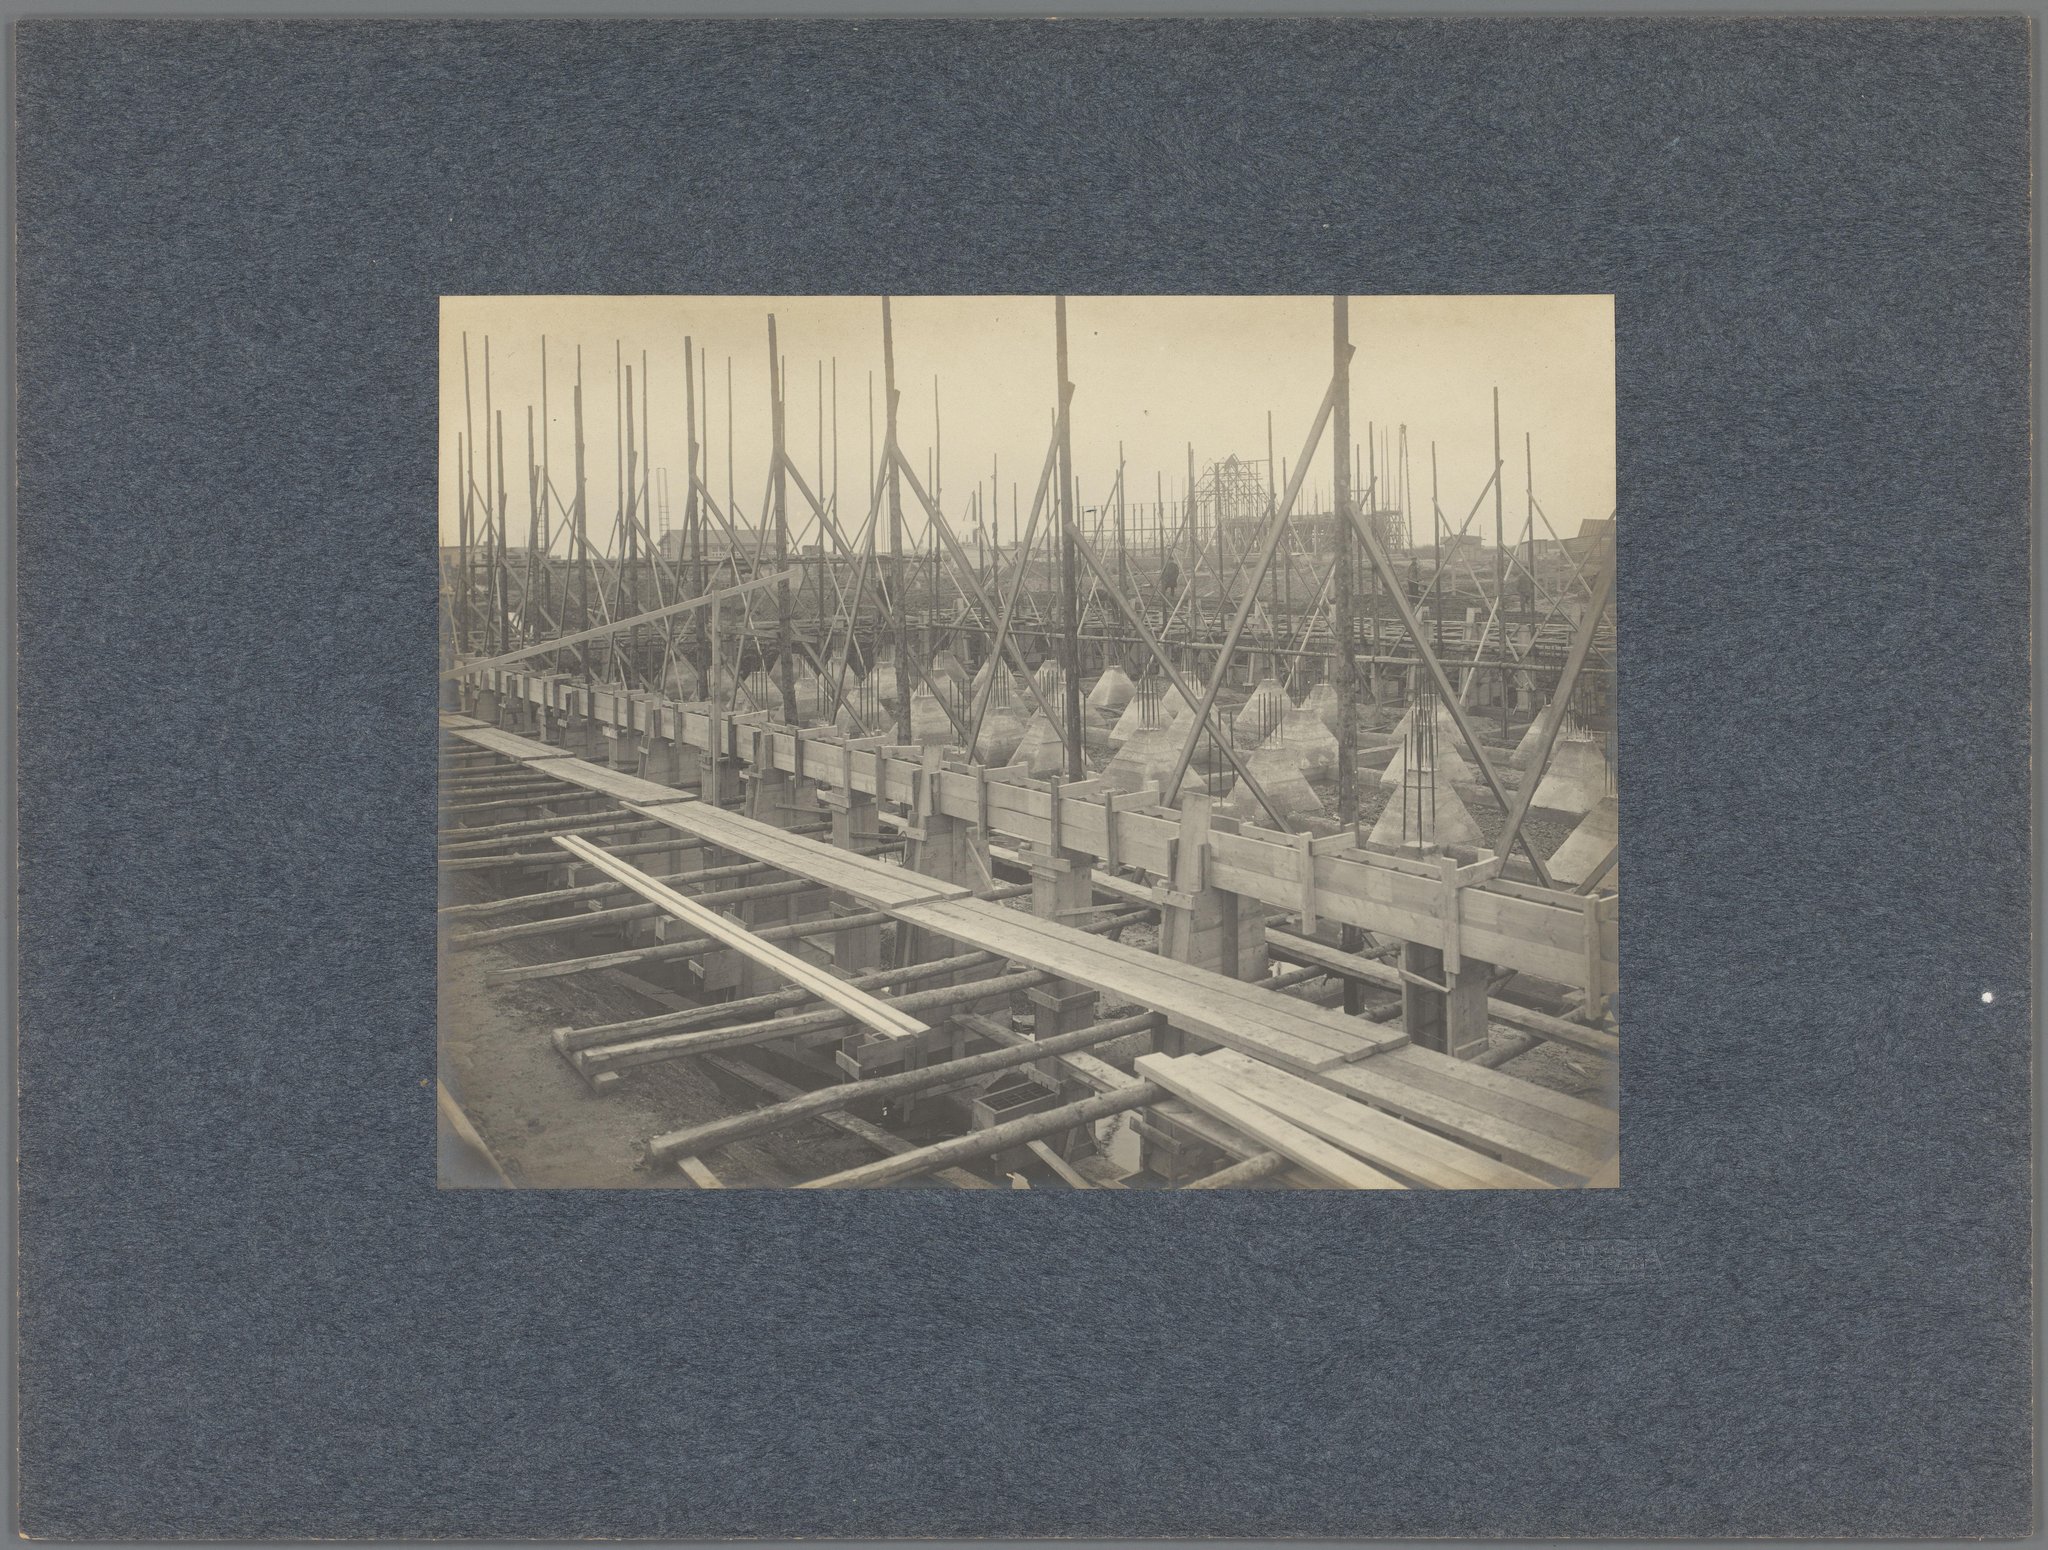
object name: photograph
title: Bouwwerkzaamheden aan de fundering van een gebouw in de haven van Rotterdam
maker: willem sr. bleuzé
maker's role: fotograaf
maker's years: 1873-1948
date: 1909-1919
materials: paper, cardboard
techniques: gelatin silver print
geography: rotterdam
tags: laying the foundations; trench, rotterdam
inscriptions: address: ‘W. BLEUZÉ/ ROTTERDAM/ JONKER FRANSSTRAAT 66’